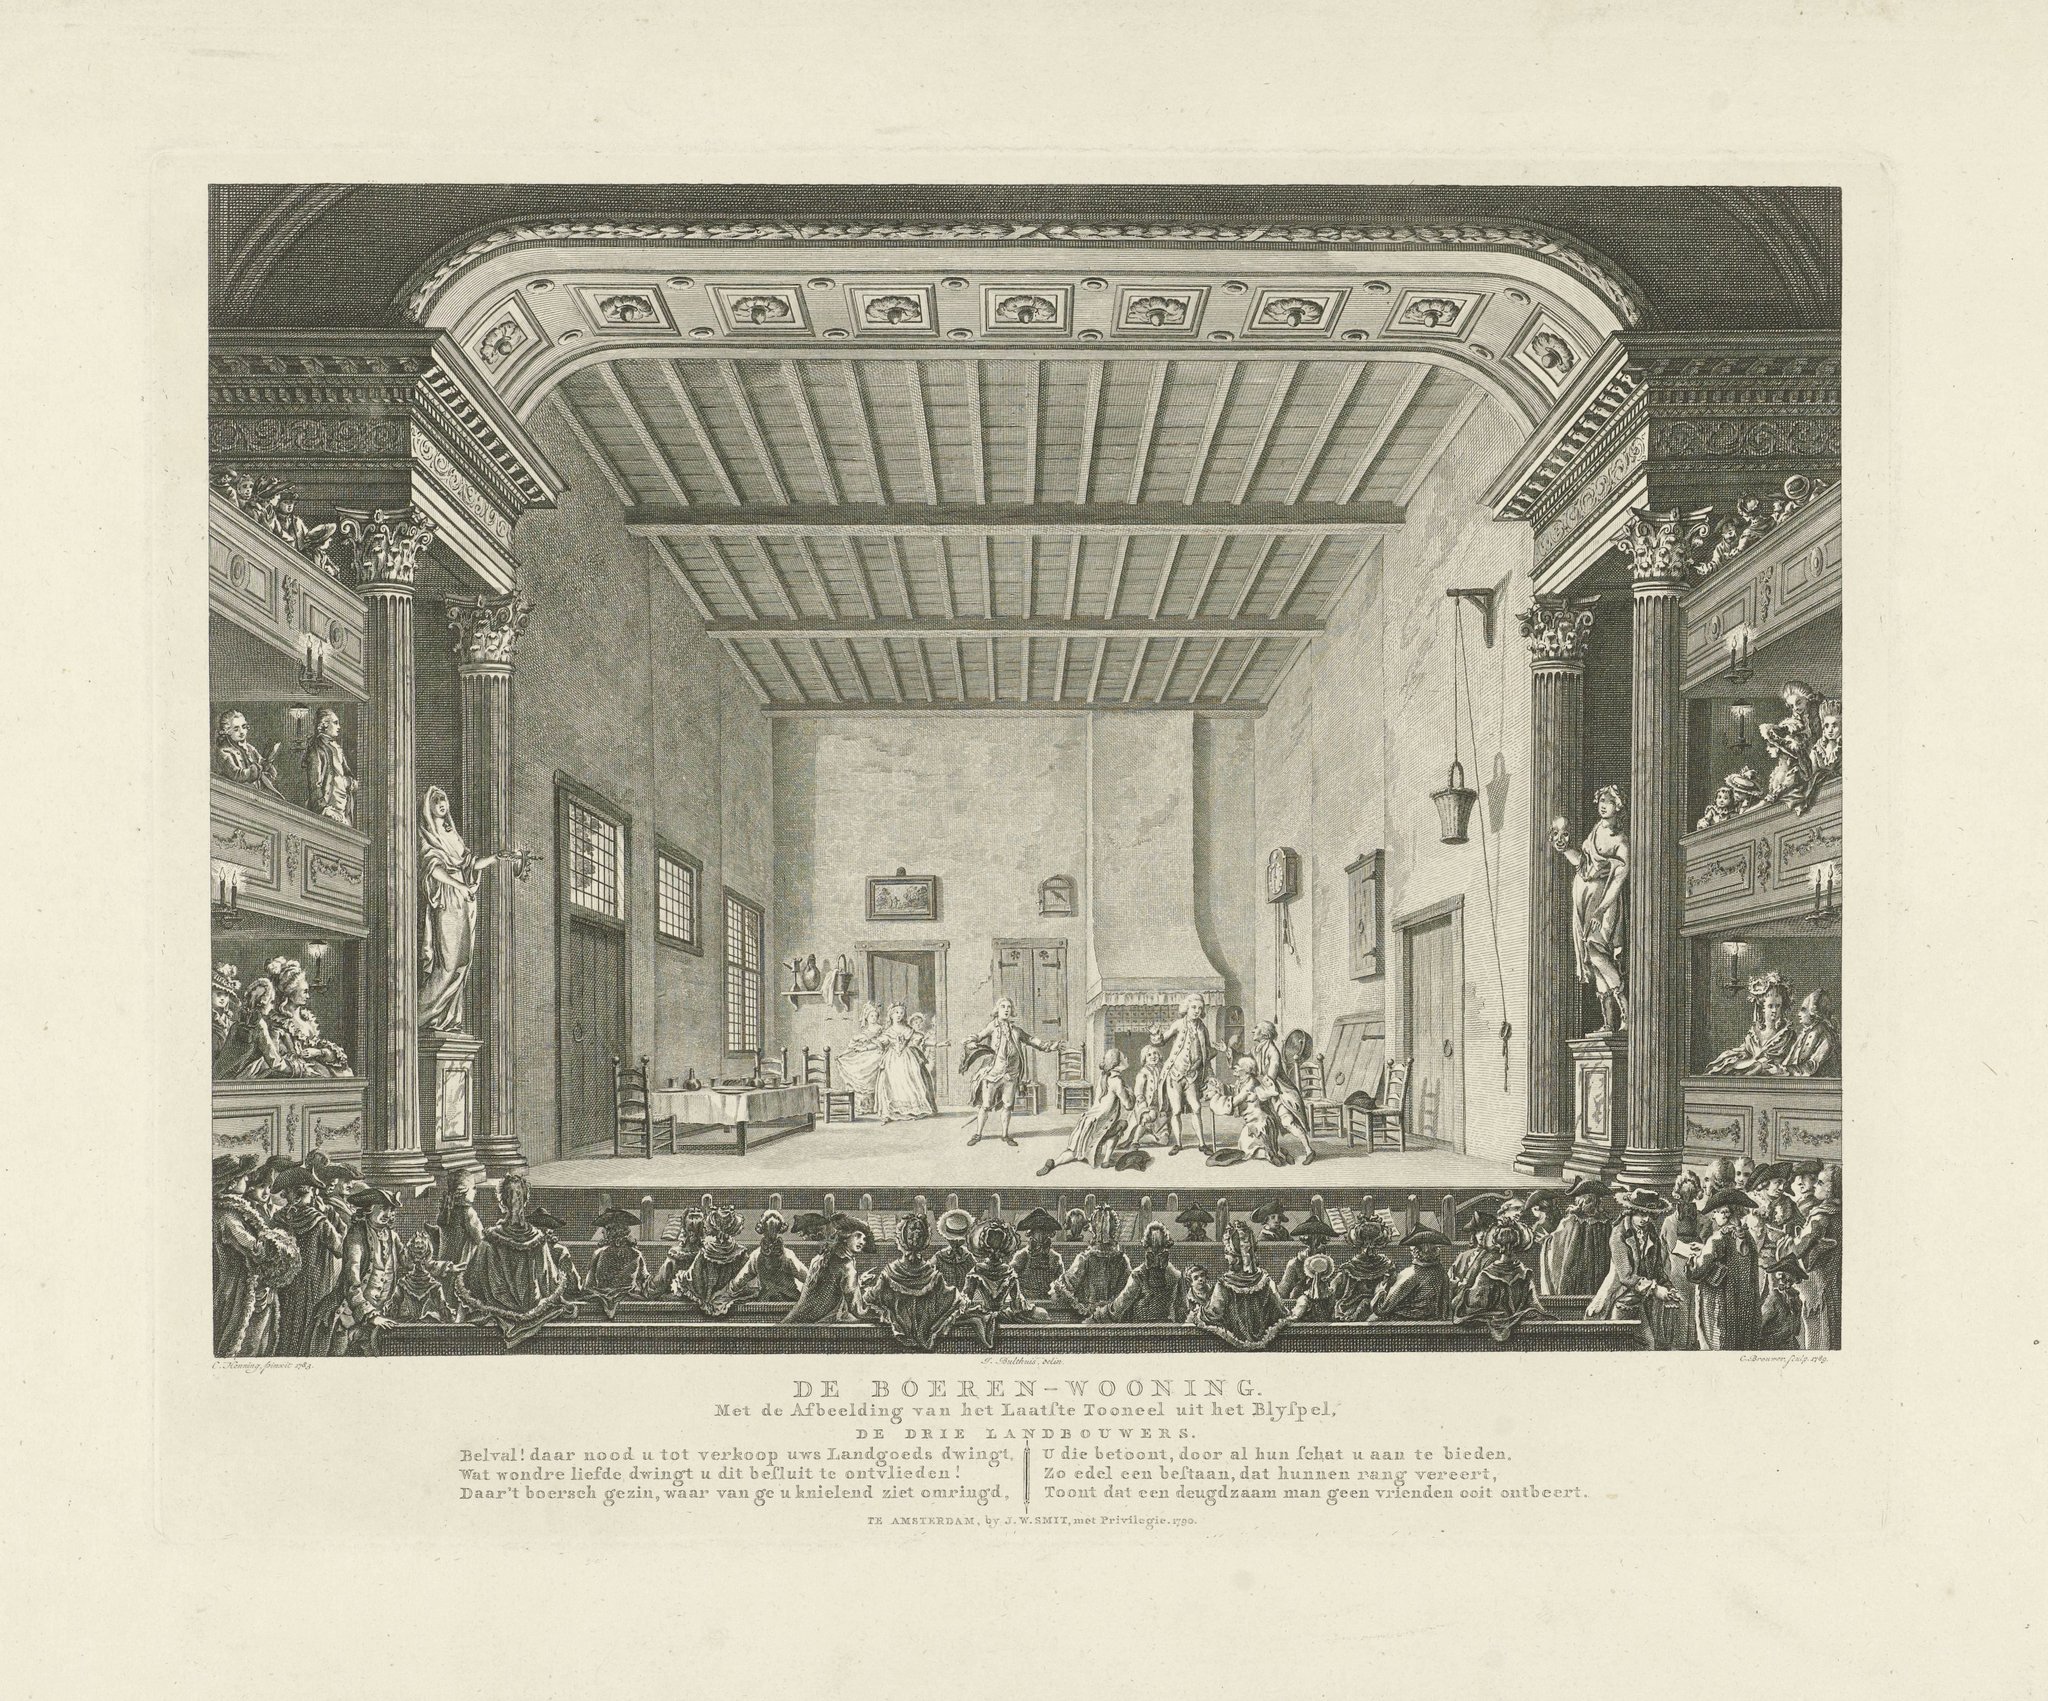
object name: print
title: Toneeldecors van de nieuwe Amsterdamse Schouwburg, 1787-1794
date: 1789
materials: paper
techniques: engraving, etching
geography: northern netherlands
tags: theatre, theatrical performance, stage design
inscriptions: collector's mark: Lugt 2228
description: Toneelvoorstelling in de nieuwe Amsterdamse Schouwburg met het coulissendecor De Boeren-wooning, met scène uit De Drie Landbouwers. Het decor gedrukt van een aparte plaat binnen een passe-partout met de zaal, zijloges, pilaren met standbeelden en de façade van het toneel. In het onderschrift een zesregelig vers. Onderdeel van de serie van veertien toneeldecors van de nieuwe Amsterdamse Schouwburg, 1787-1794.